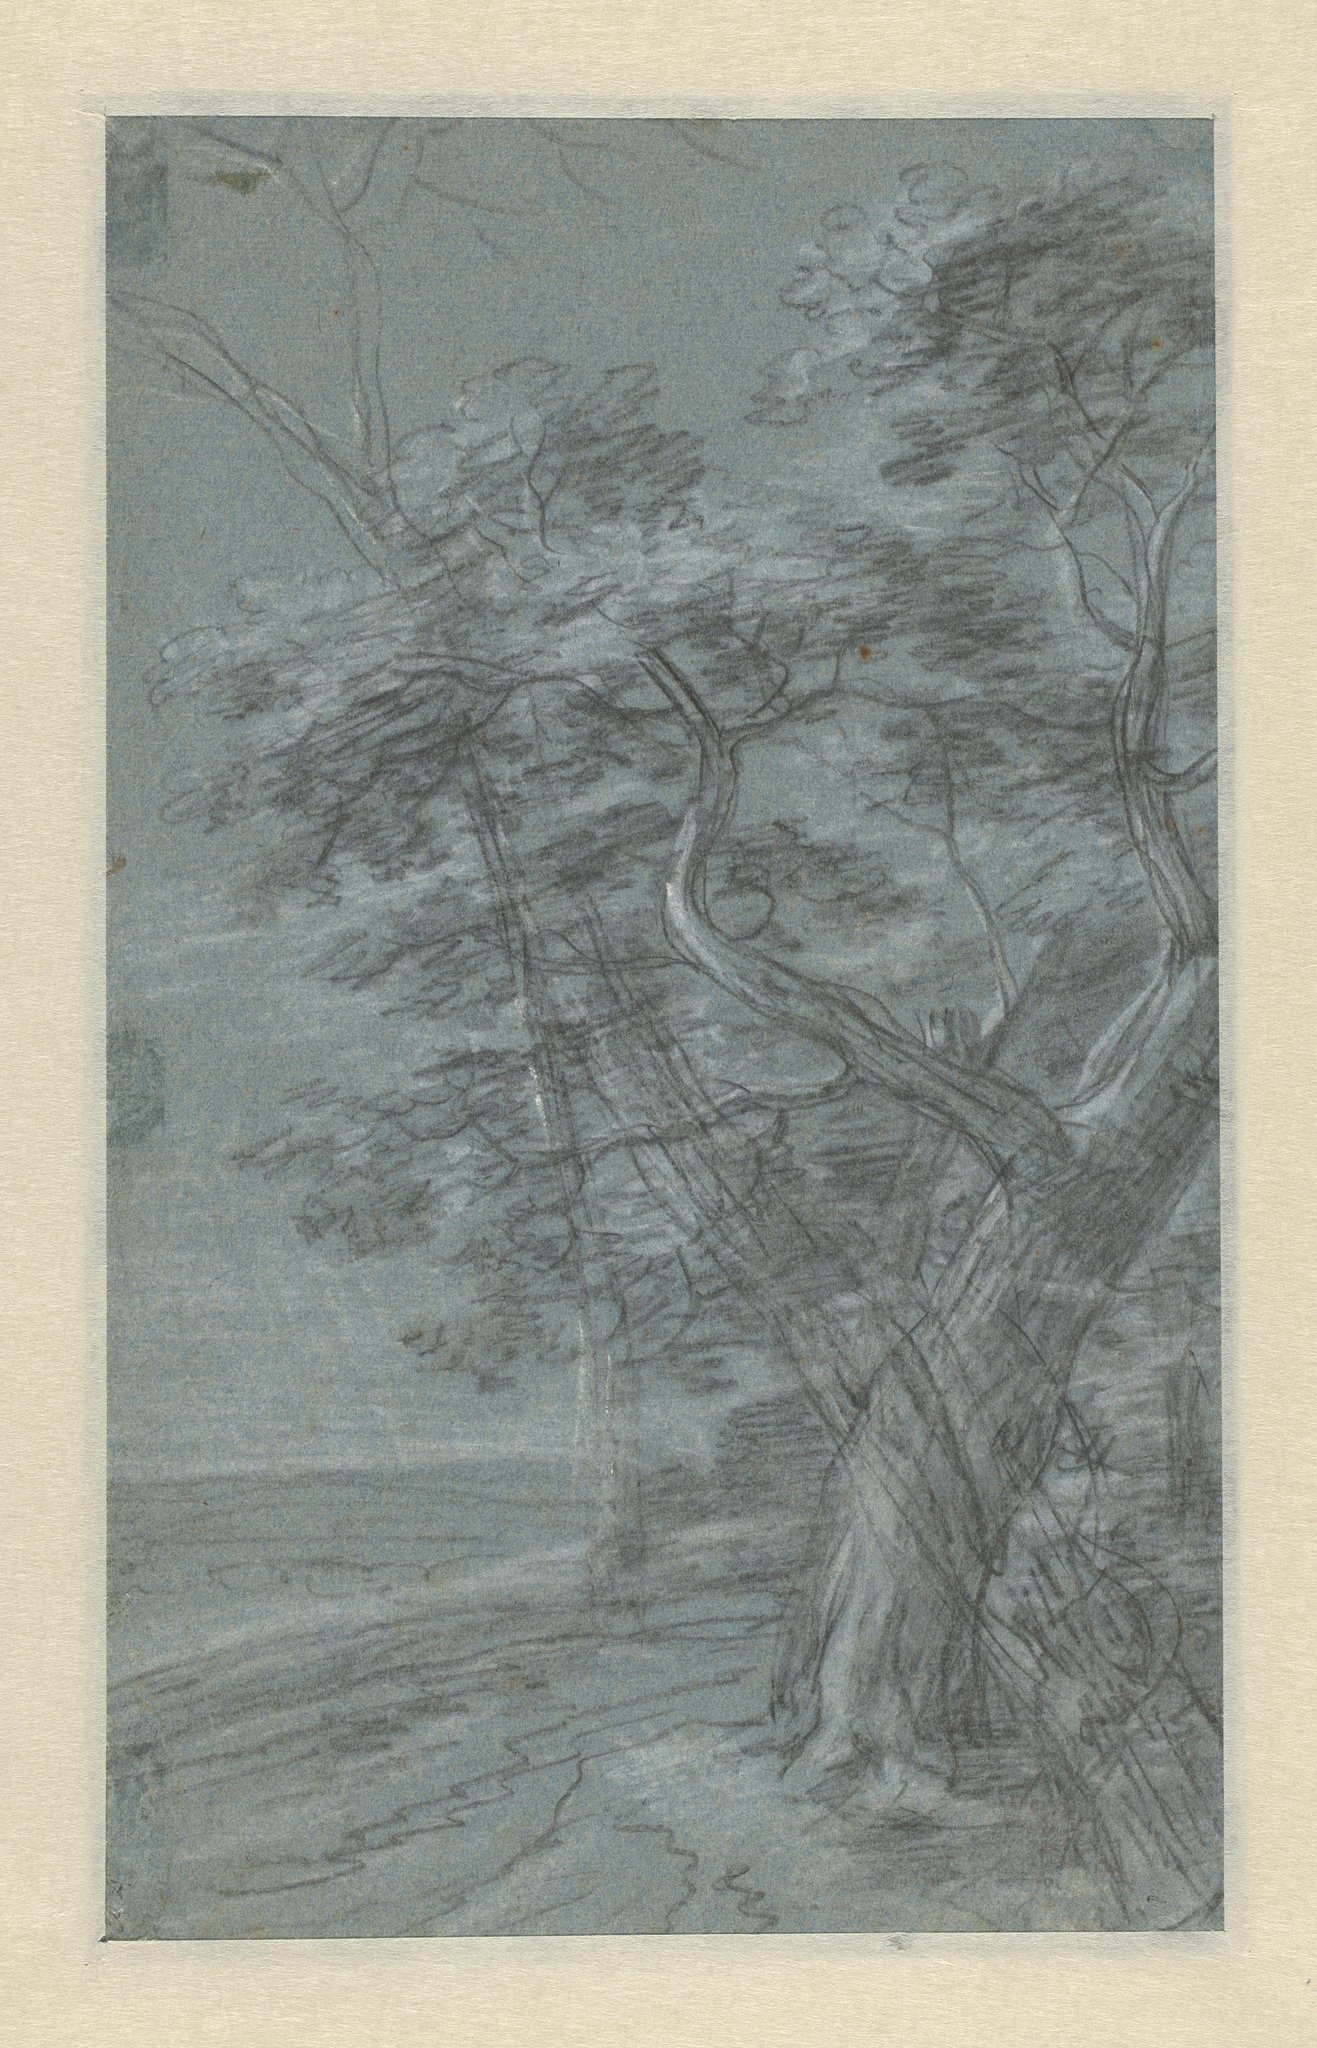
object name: drawing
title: Boomstudie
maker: willem schellinks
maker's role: draughtsman, painter, print maker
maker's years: 1627-1678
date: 1637-1678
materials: chalk, paper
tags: trees